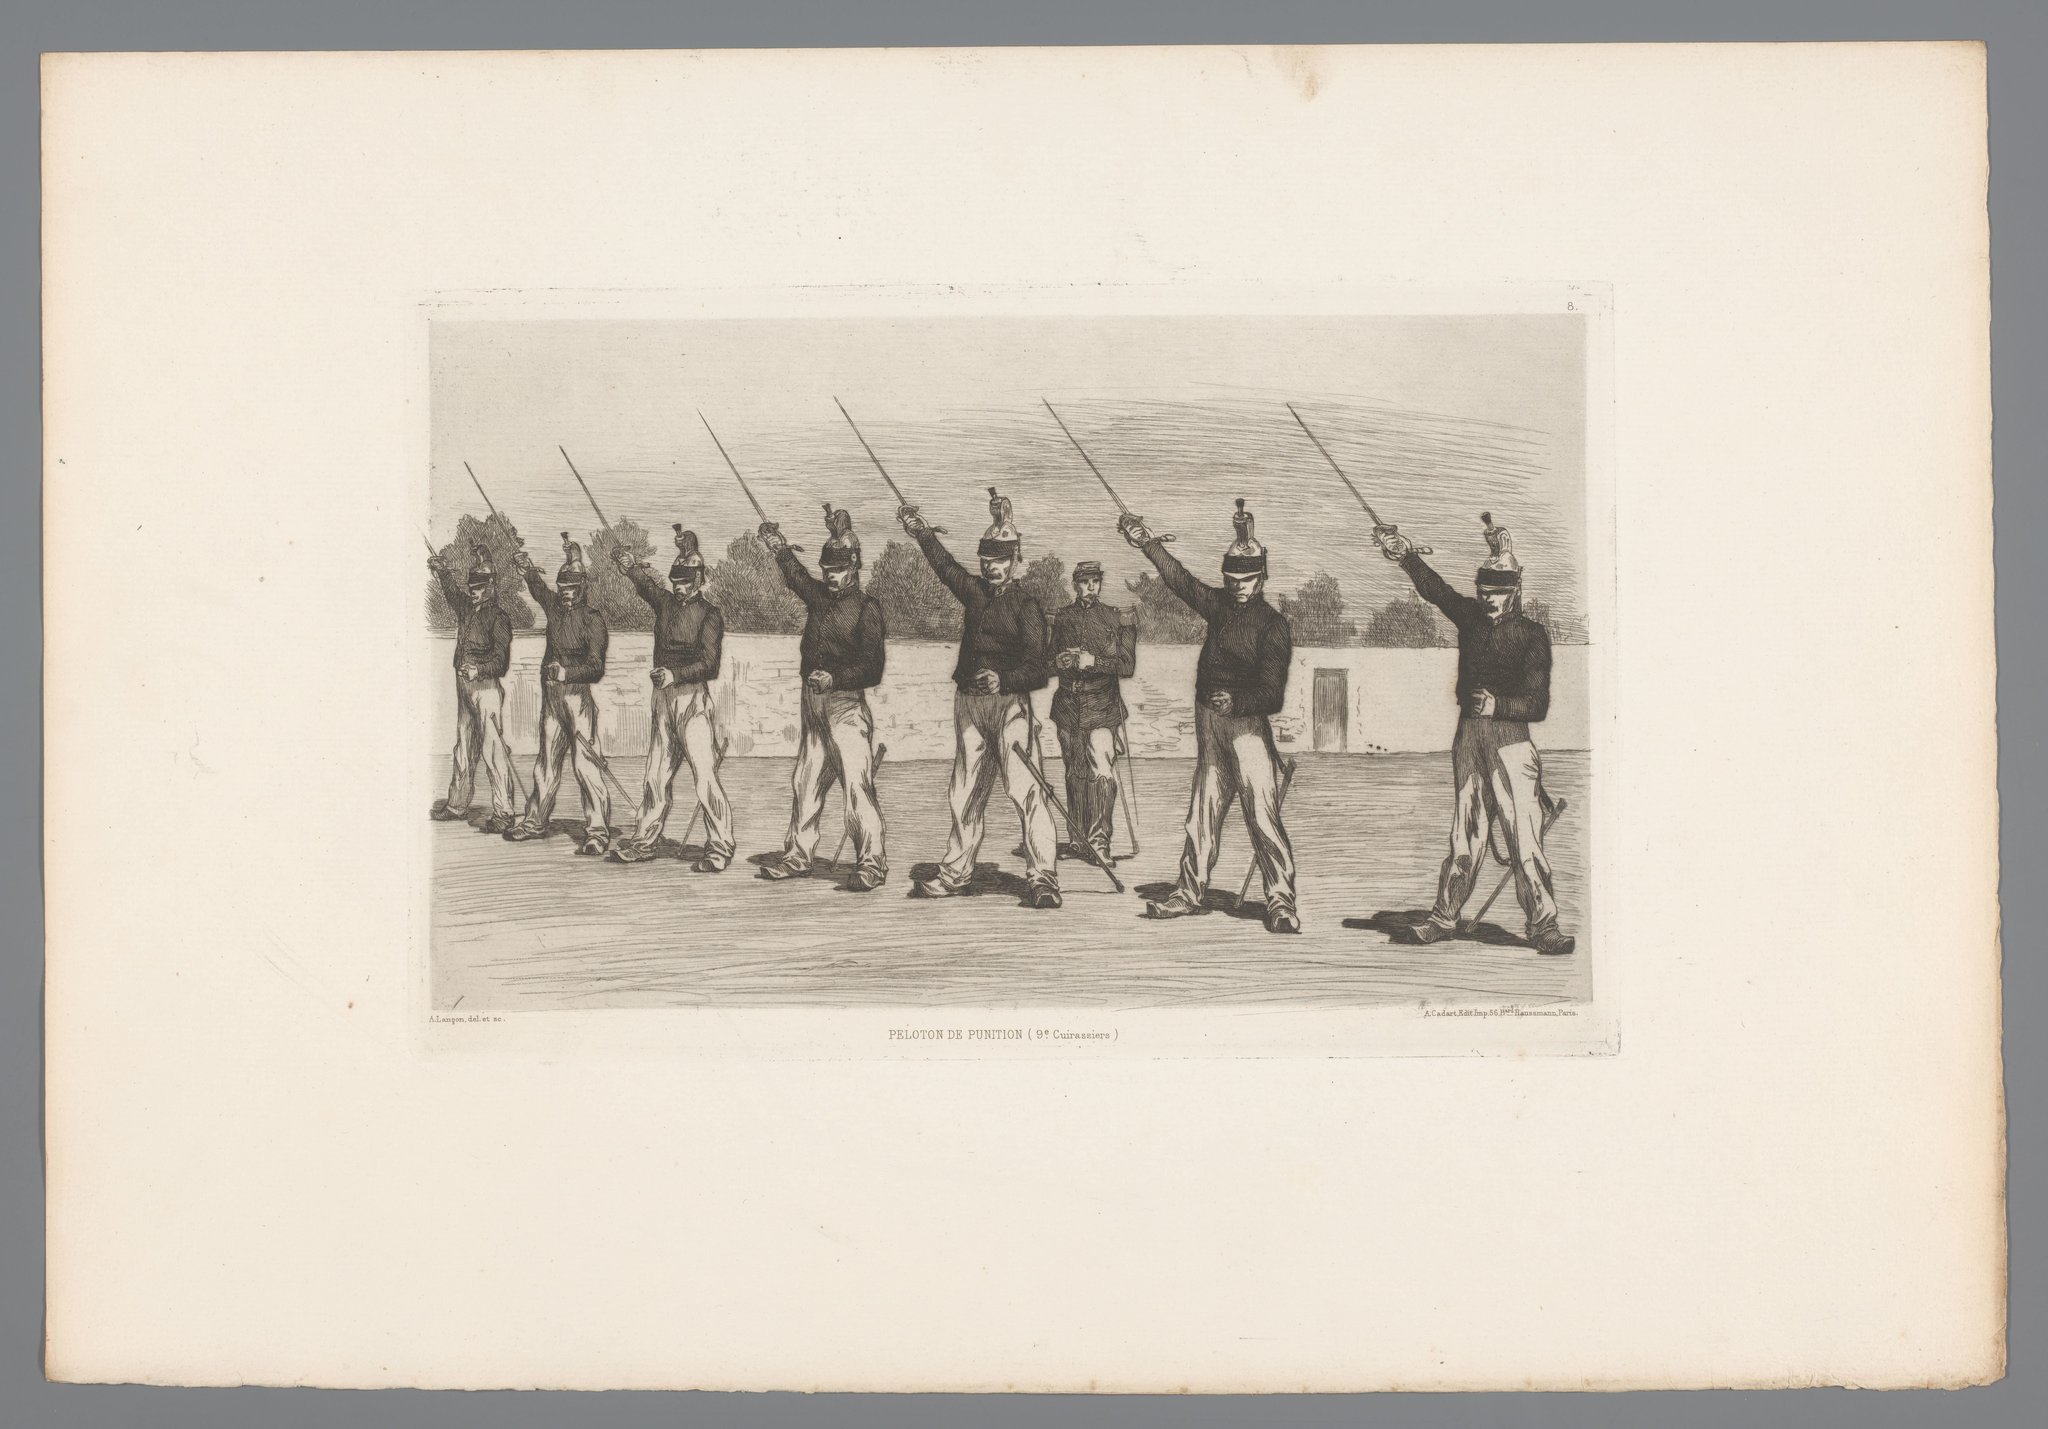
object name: print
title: L'eau-forte en 1875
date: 1875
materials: paper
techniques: drypoint, etching, intaglio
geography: paris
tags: ranks in the army, hacking and thrusting weapons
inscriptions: collector's mark: Lugt 2760, collector's mark: ‘AFE v S’, collector's mark: Lugt 2228